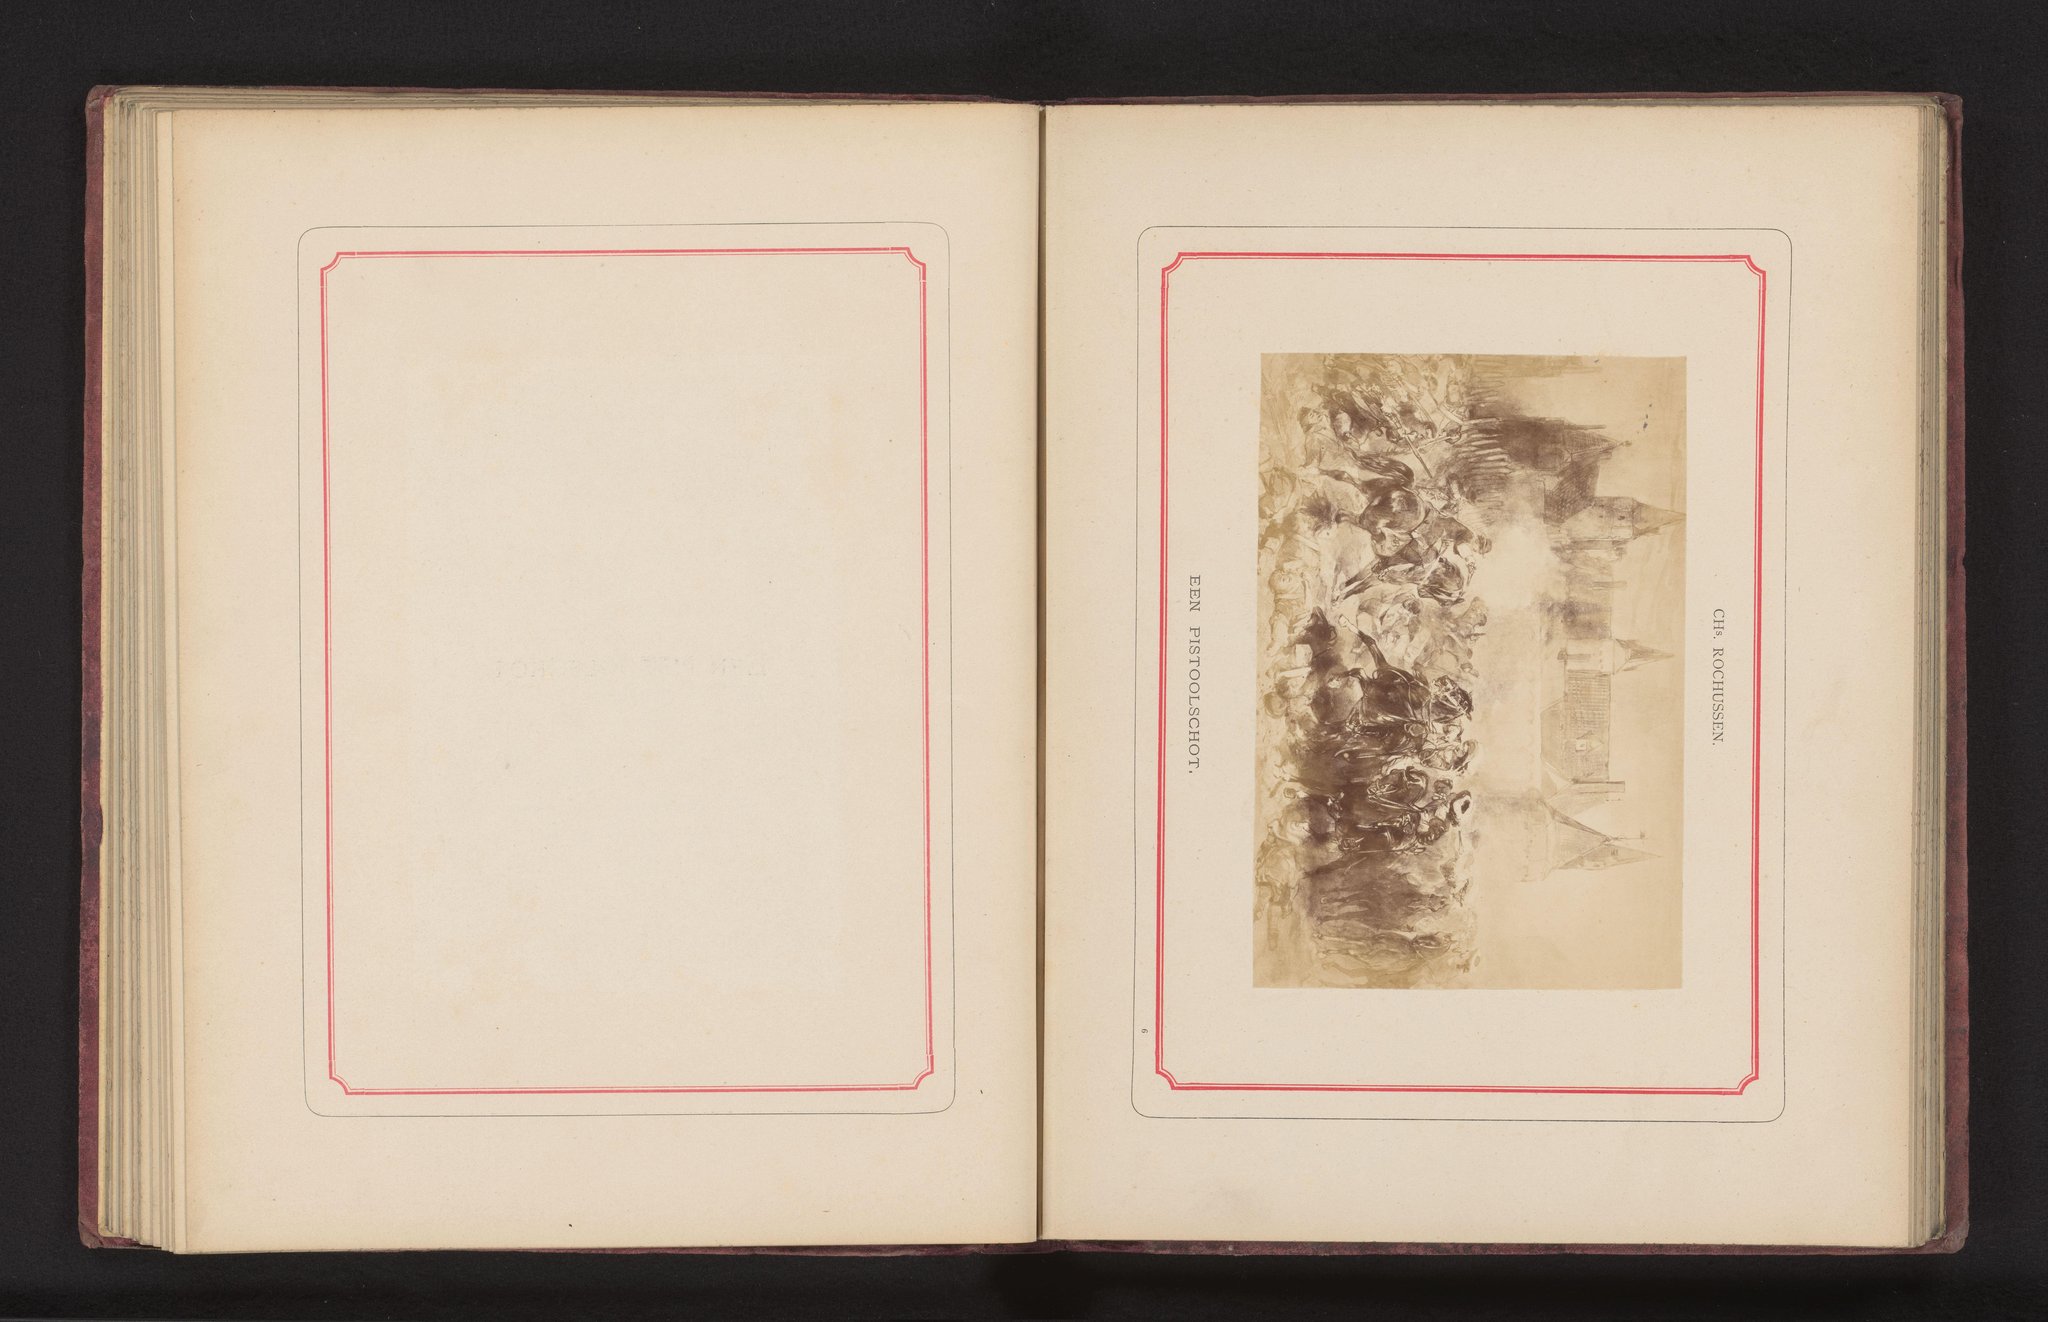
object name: page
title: Een pistoolschot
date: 1868-1878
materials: photographic support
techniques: albumen print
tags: riding a horse, ass, or mule; rider, horseman, battle